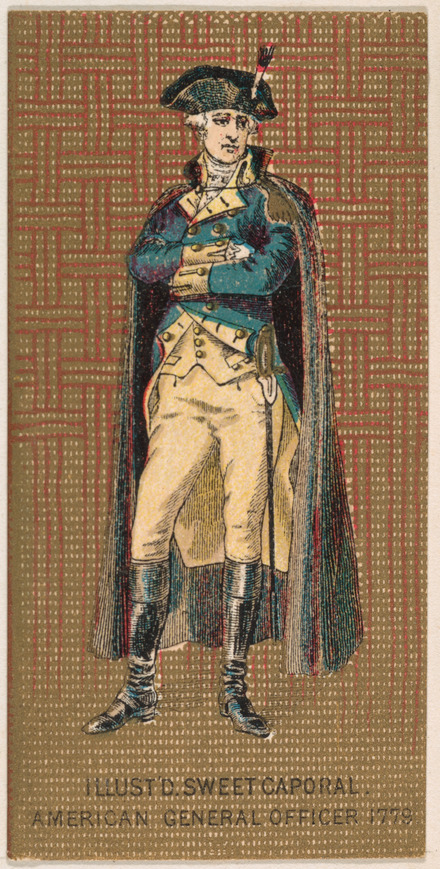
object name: print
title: American General Officer, 1779, from the Military Series (N224) issued by Kinney Tobacco Company to promote Sweet Caporal Cigarettes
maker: kinney brothers tobacco company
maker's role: publisher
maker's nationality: american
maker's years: 1869-2011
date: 1888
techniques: color lithograph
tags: men,generals